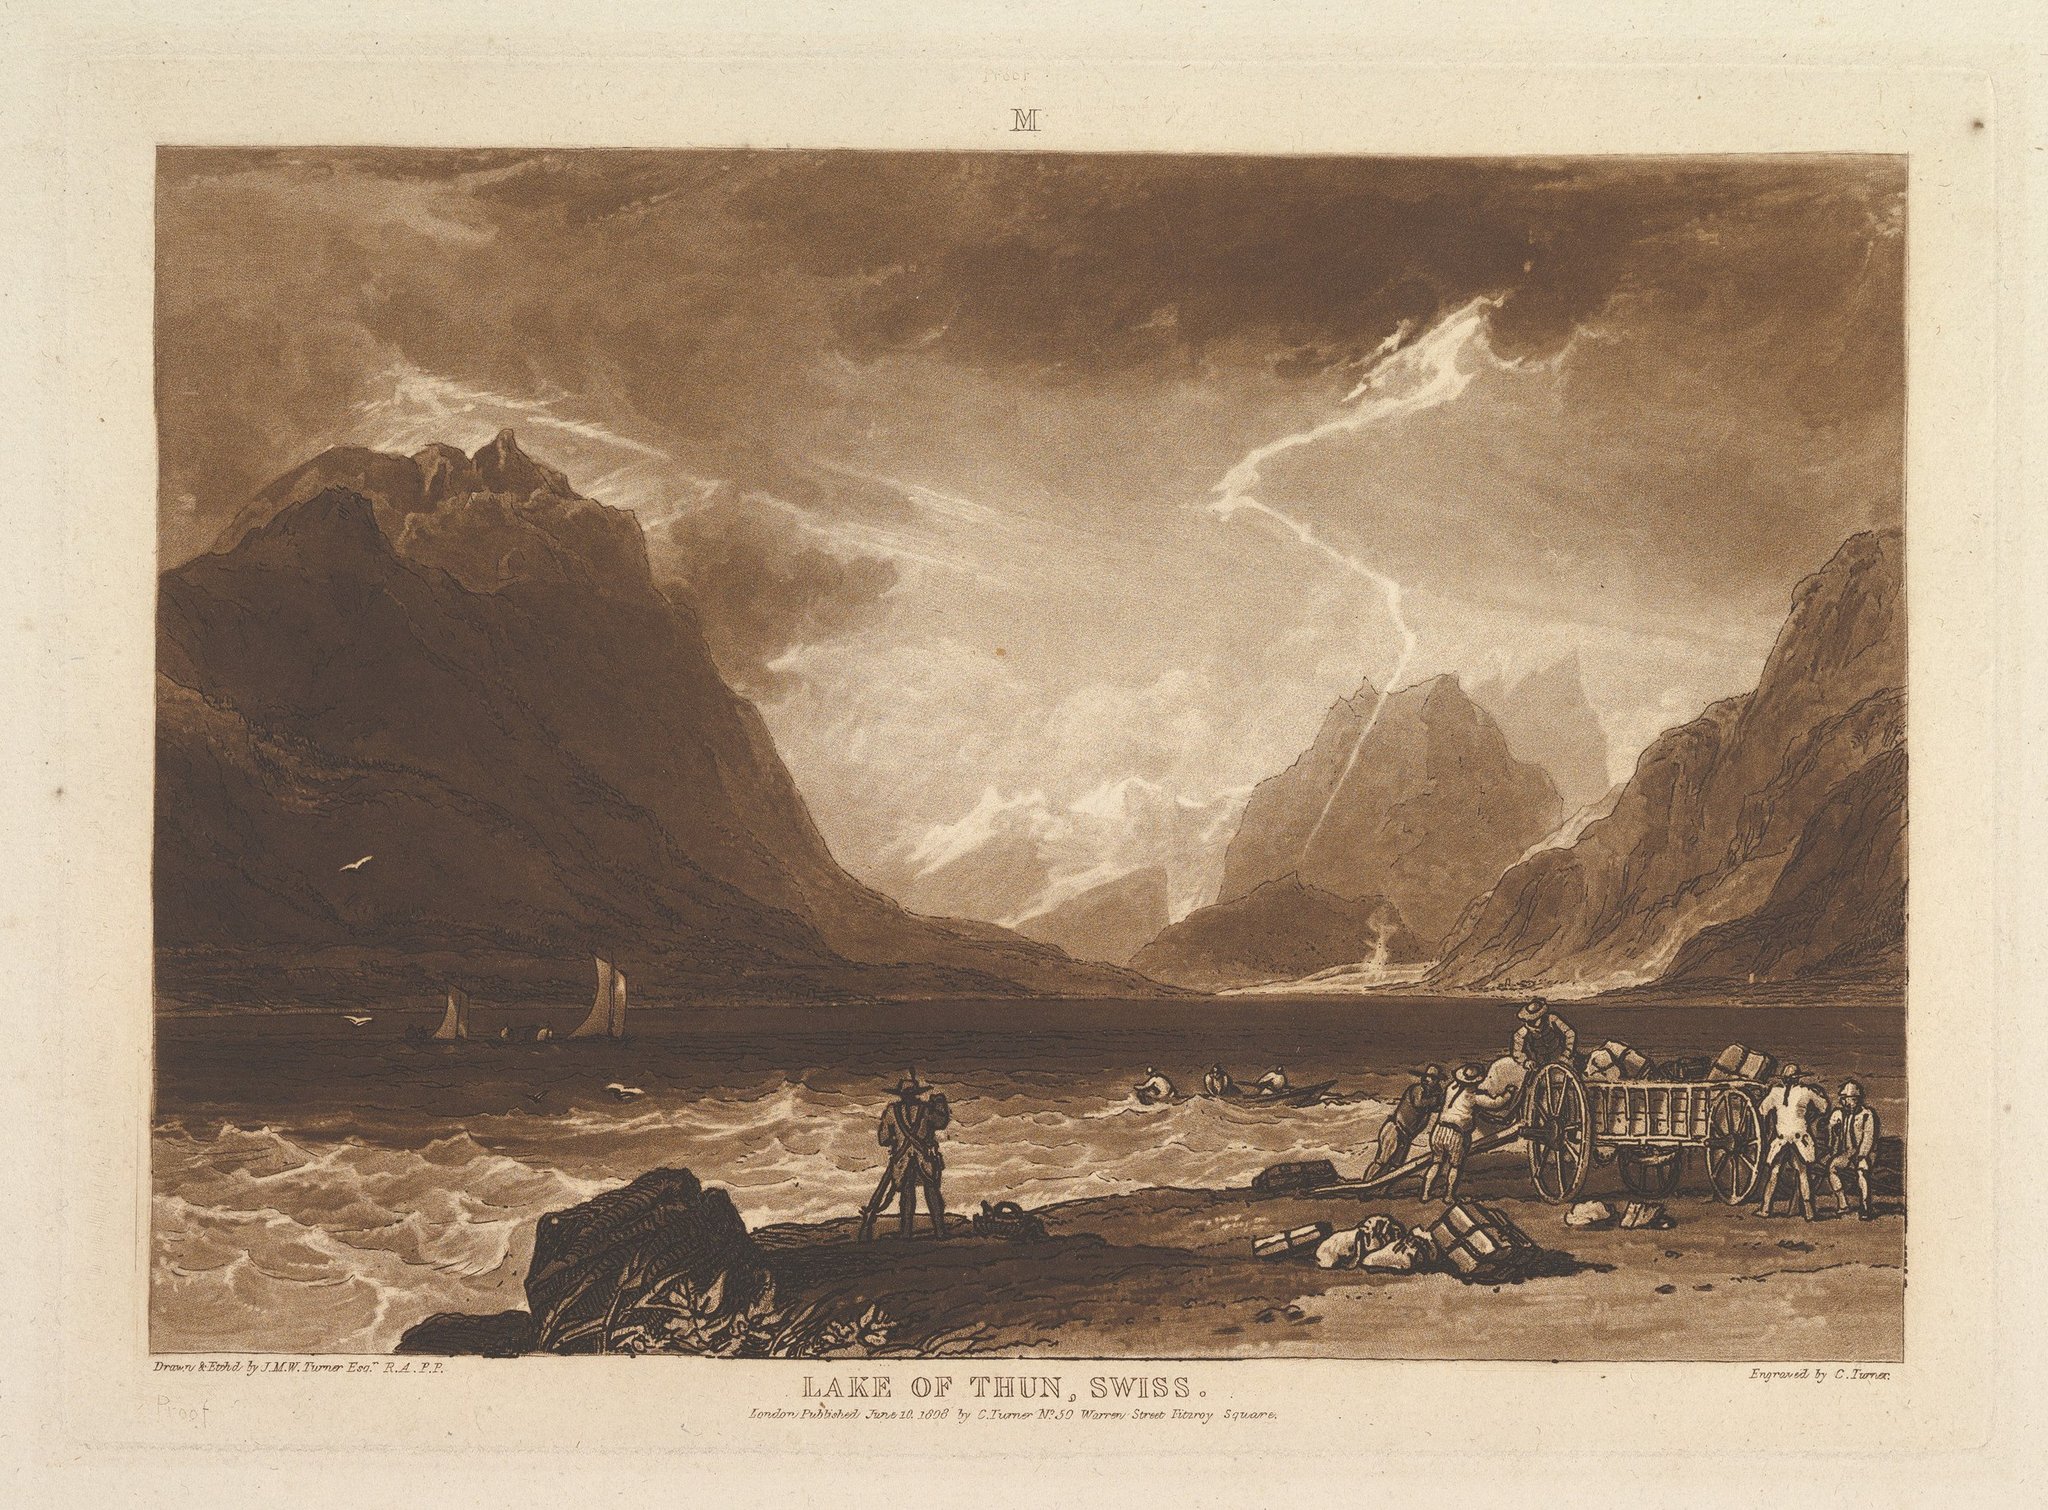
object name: print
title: Lake of Thun, Swiss, part III, plate 15 from "Liber Studiorum"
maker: joseph mallord william turner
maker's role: artist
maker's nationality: british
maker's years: 1775-1851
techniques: drypoint, etching, mezzotint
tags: men,lakes,mountains,waves,carts